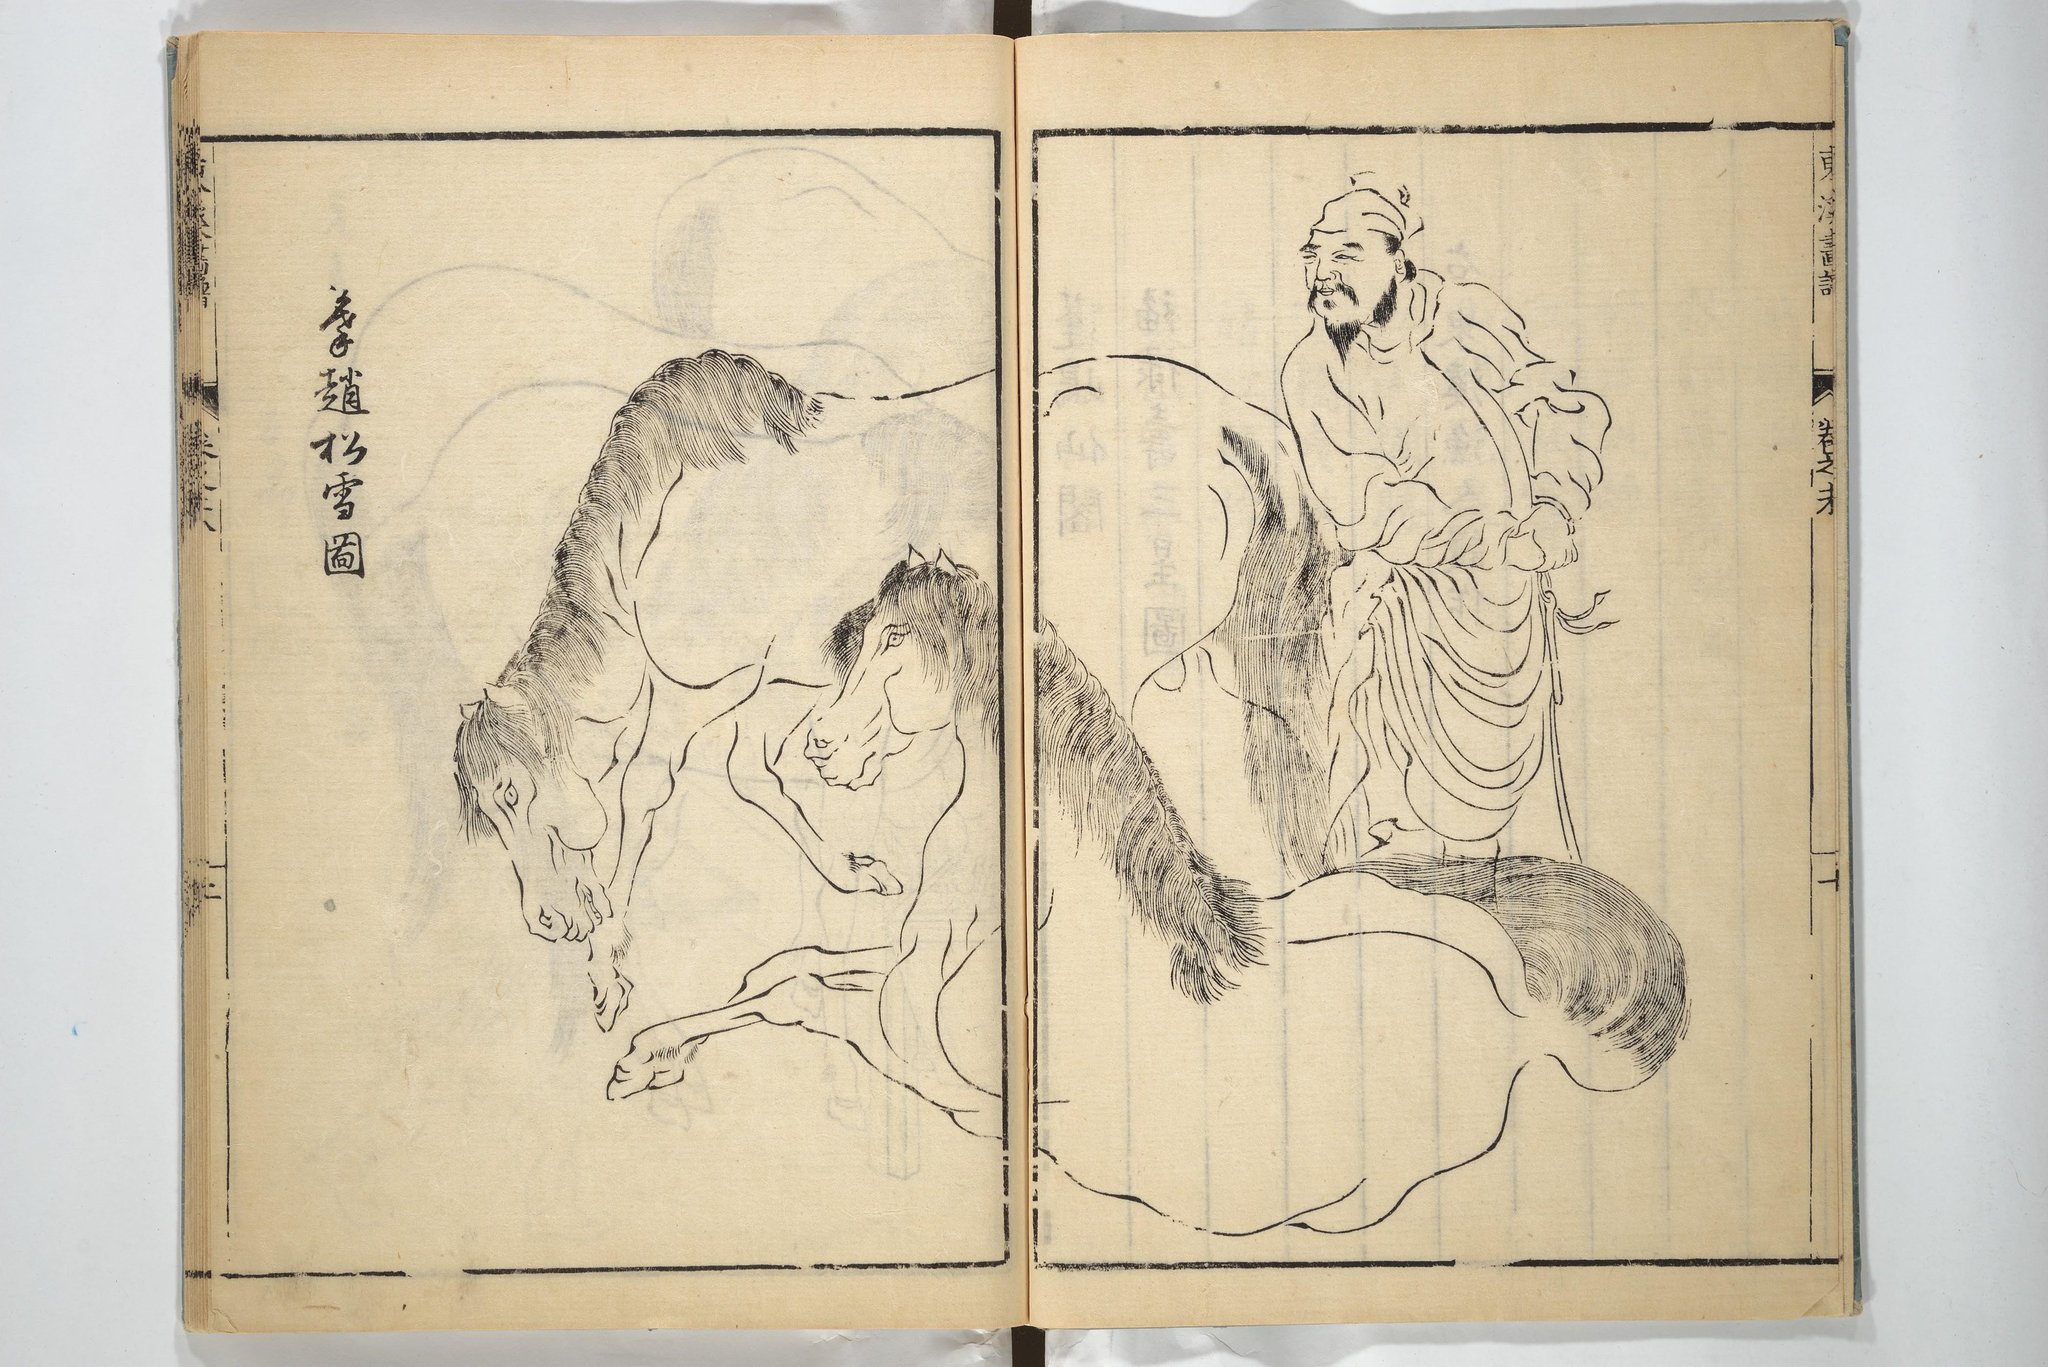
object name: illustrated book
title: Tōkei Picture Album (Tōkei gafu, fusatsu), Supplementary Series 東渓画譜 附冊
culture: japanese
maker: ogura tōkei 小倉東渓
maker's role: artist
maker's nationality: japanese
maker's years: 1750-1799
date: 1809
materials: ink, paper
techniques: woodblock print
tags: men,horses